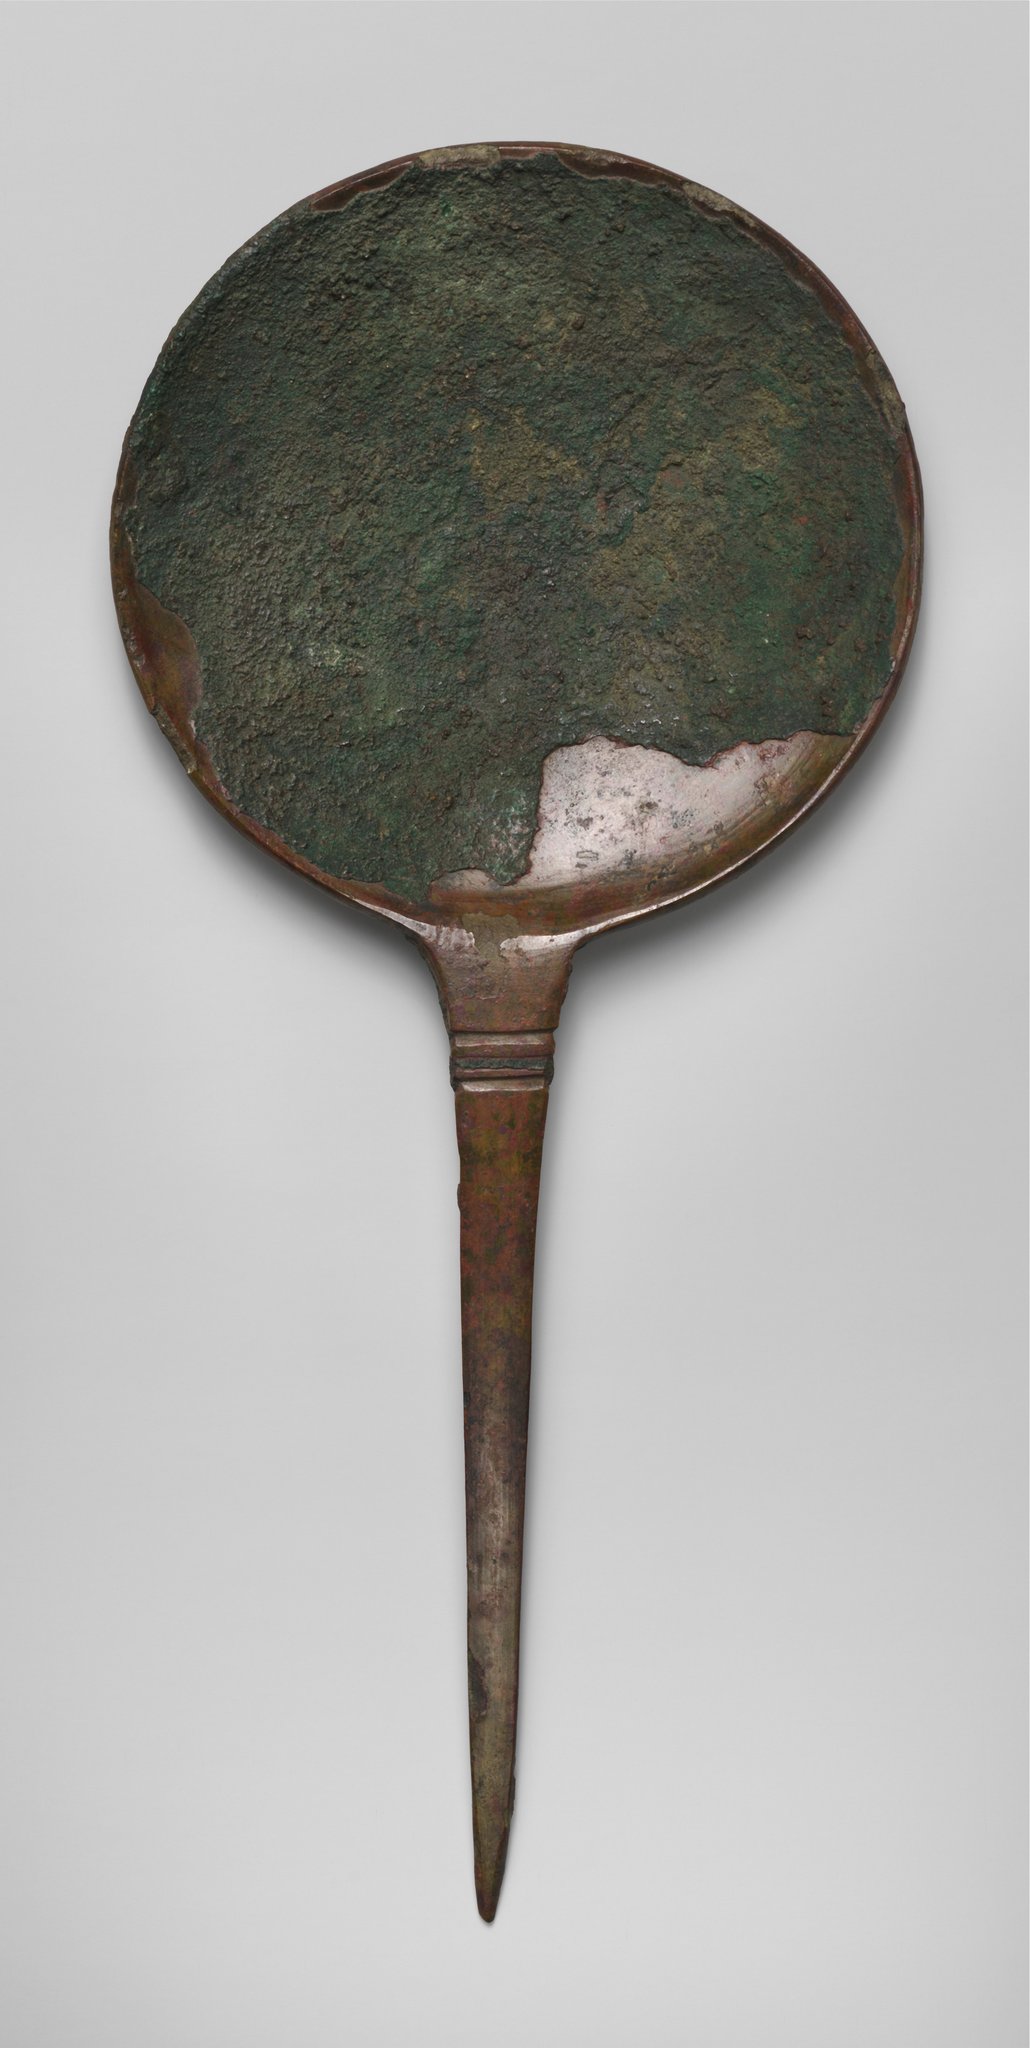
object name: spatula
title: Spatula (?)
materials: copper alloy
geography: egypt